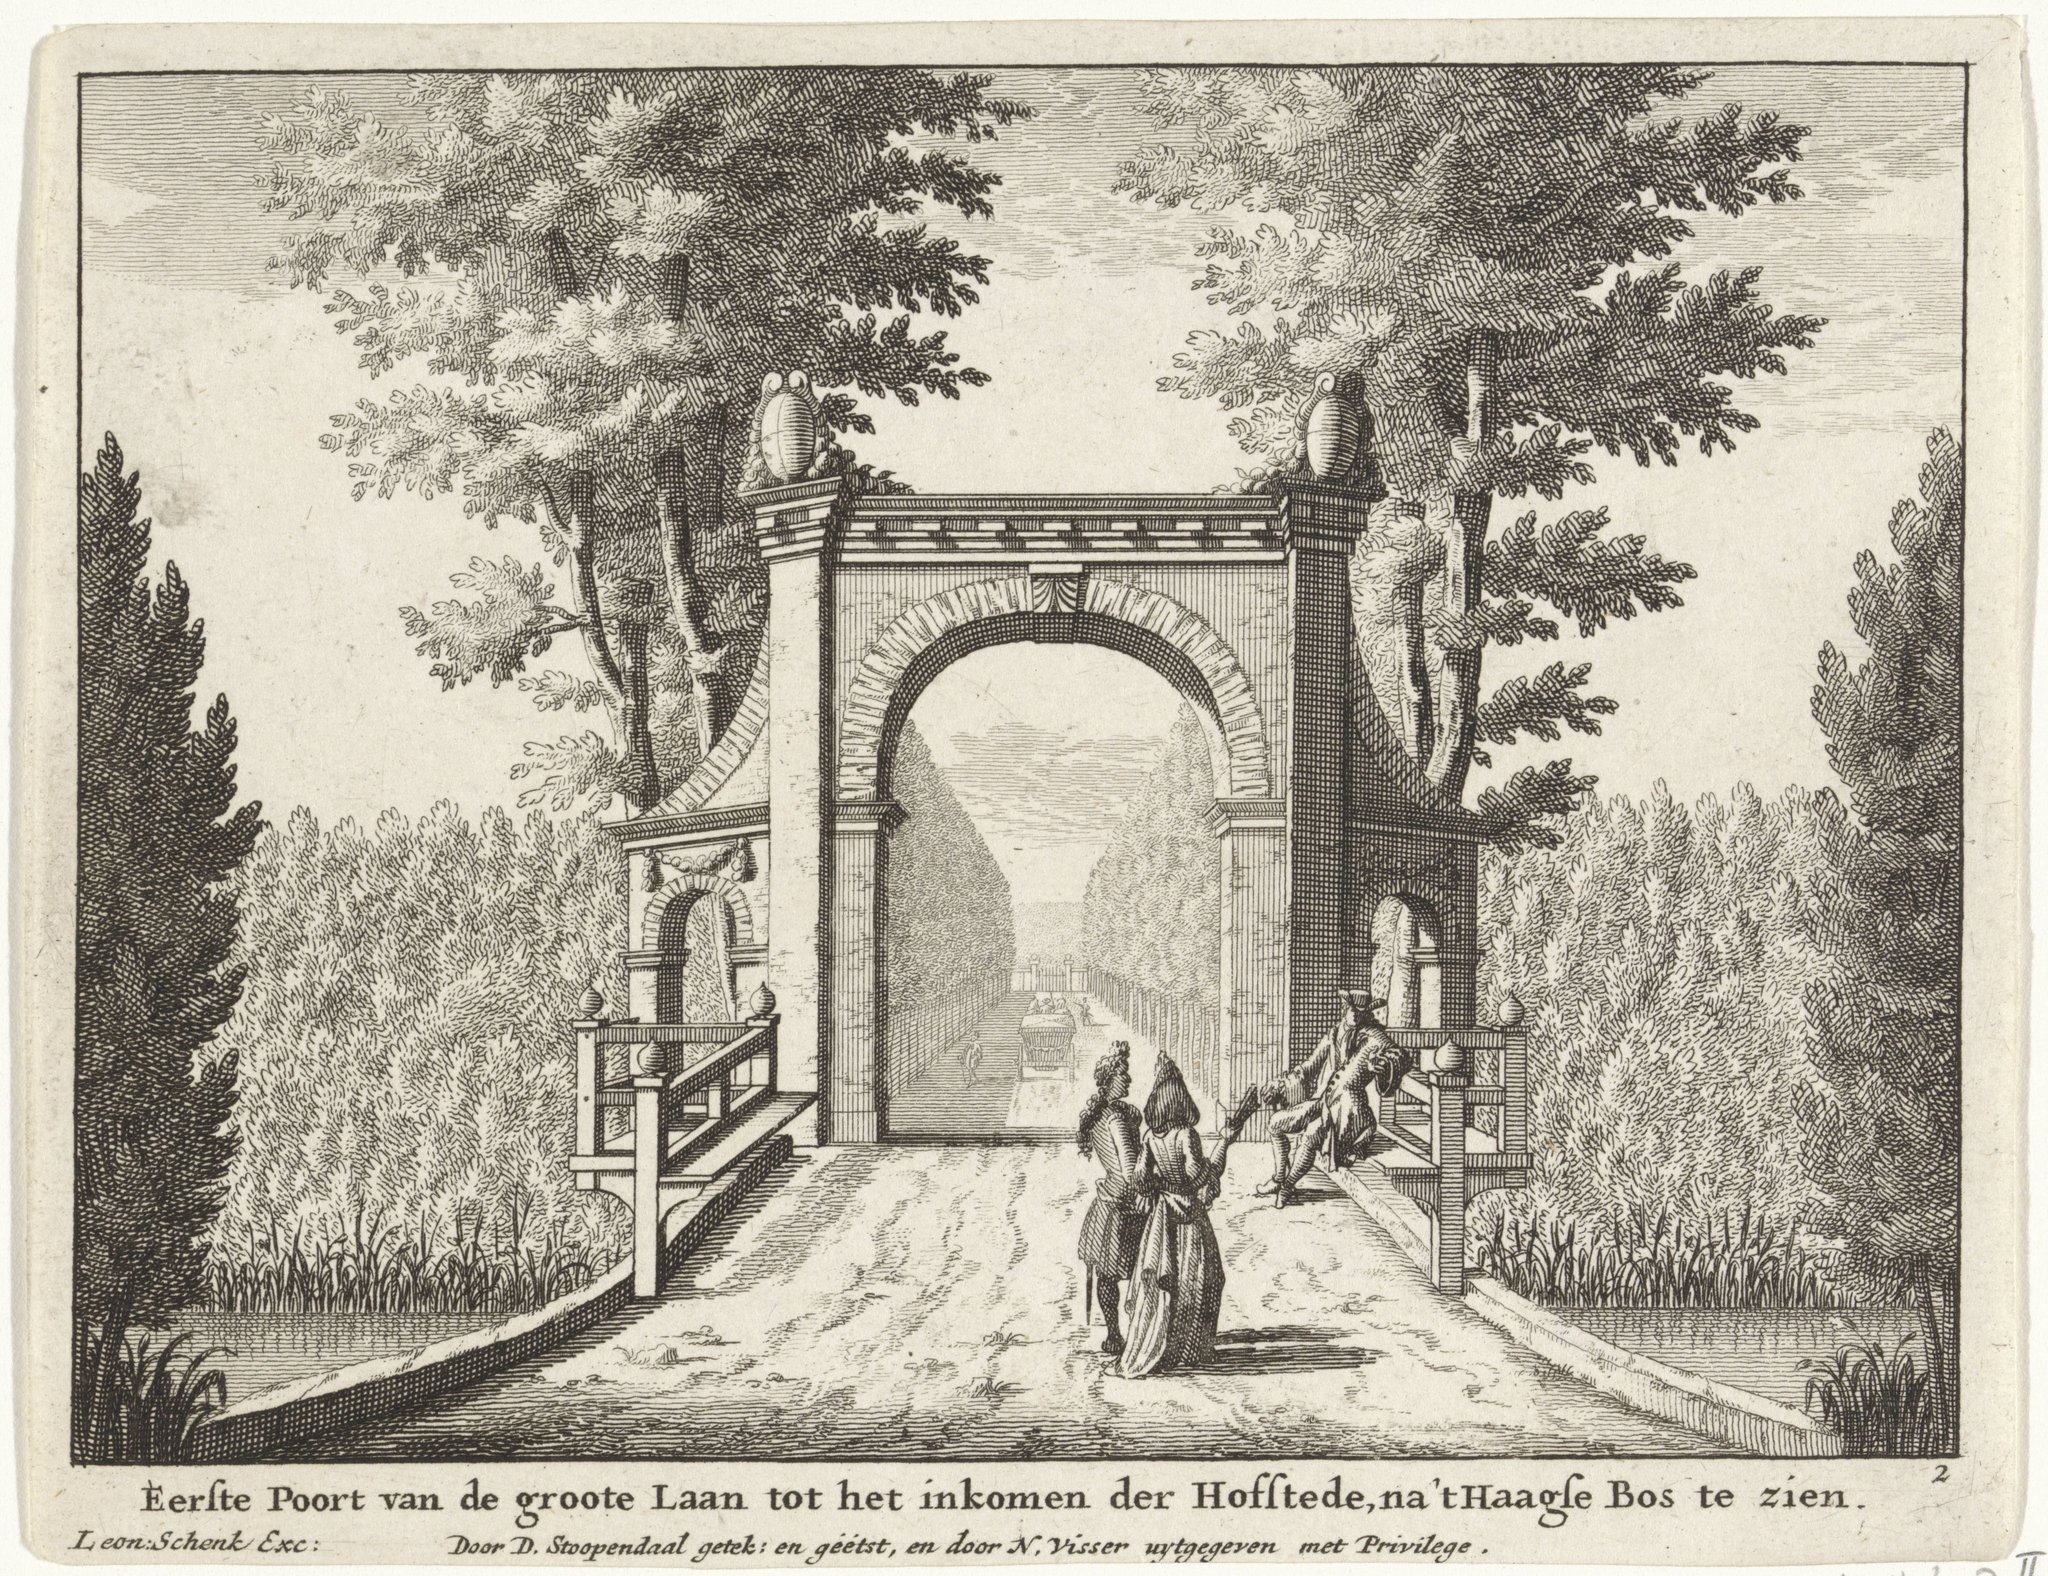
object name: print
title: Eerste poort van de grote laan op landgoed Clingendael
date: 1682-1726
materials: paper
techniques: etching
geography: amsterdam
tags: french or architectonic garden; formal garden, gate, entrance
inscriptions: collector's mark: Lugt 2228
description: Toegangspoort van landgoed Clingendael bij Den Haag. Op de weg loopt een paar gearmd. Op de brug zit een heer.